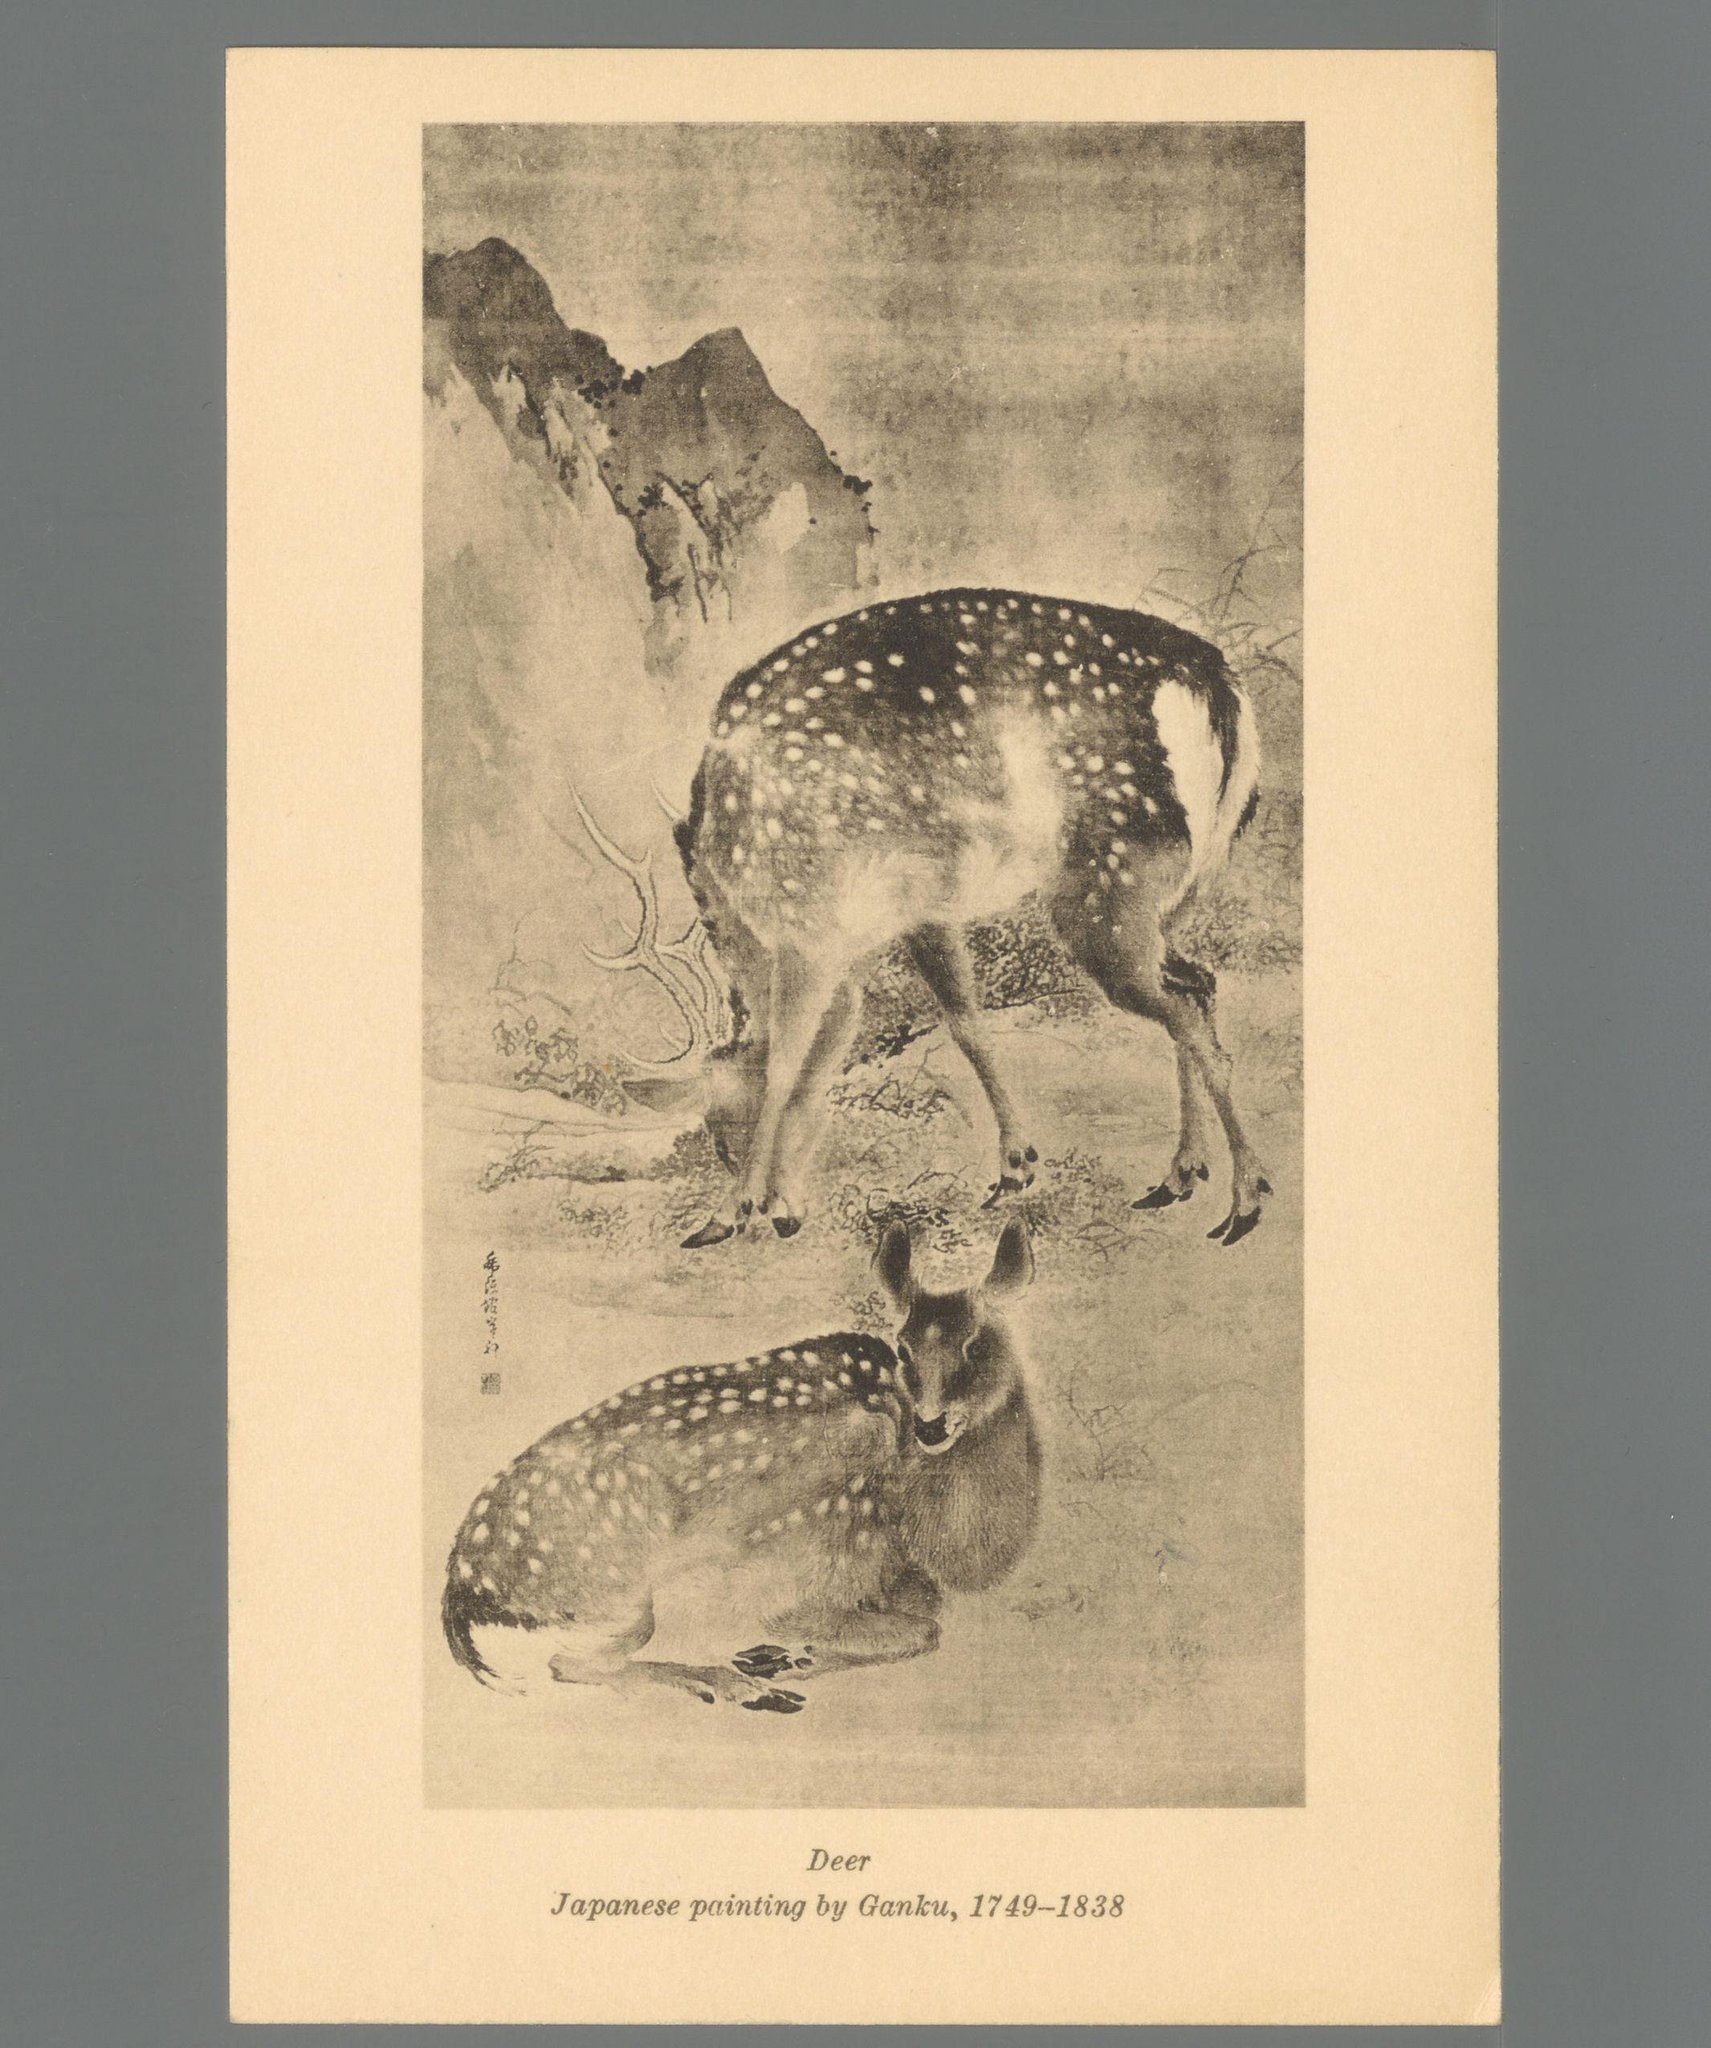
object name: photomechanical print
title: Deer. Japanese painting by Ganku, 1749-1838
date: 1911-1950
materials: cardboard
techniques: photograph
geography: oxford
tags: hoofed animals: deer, mountains